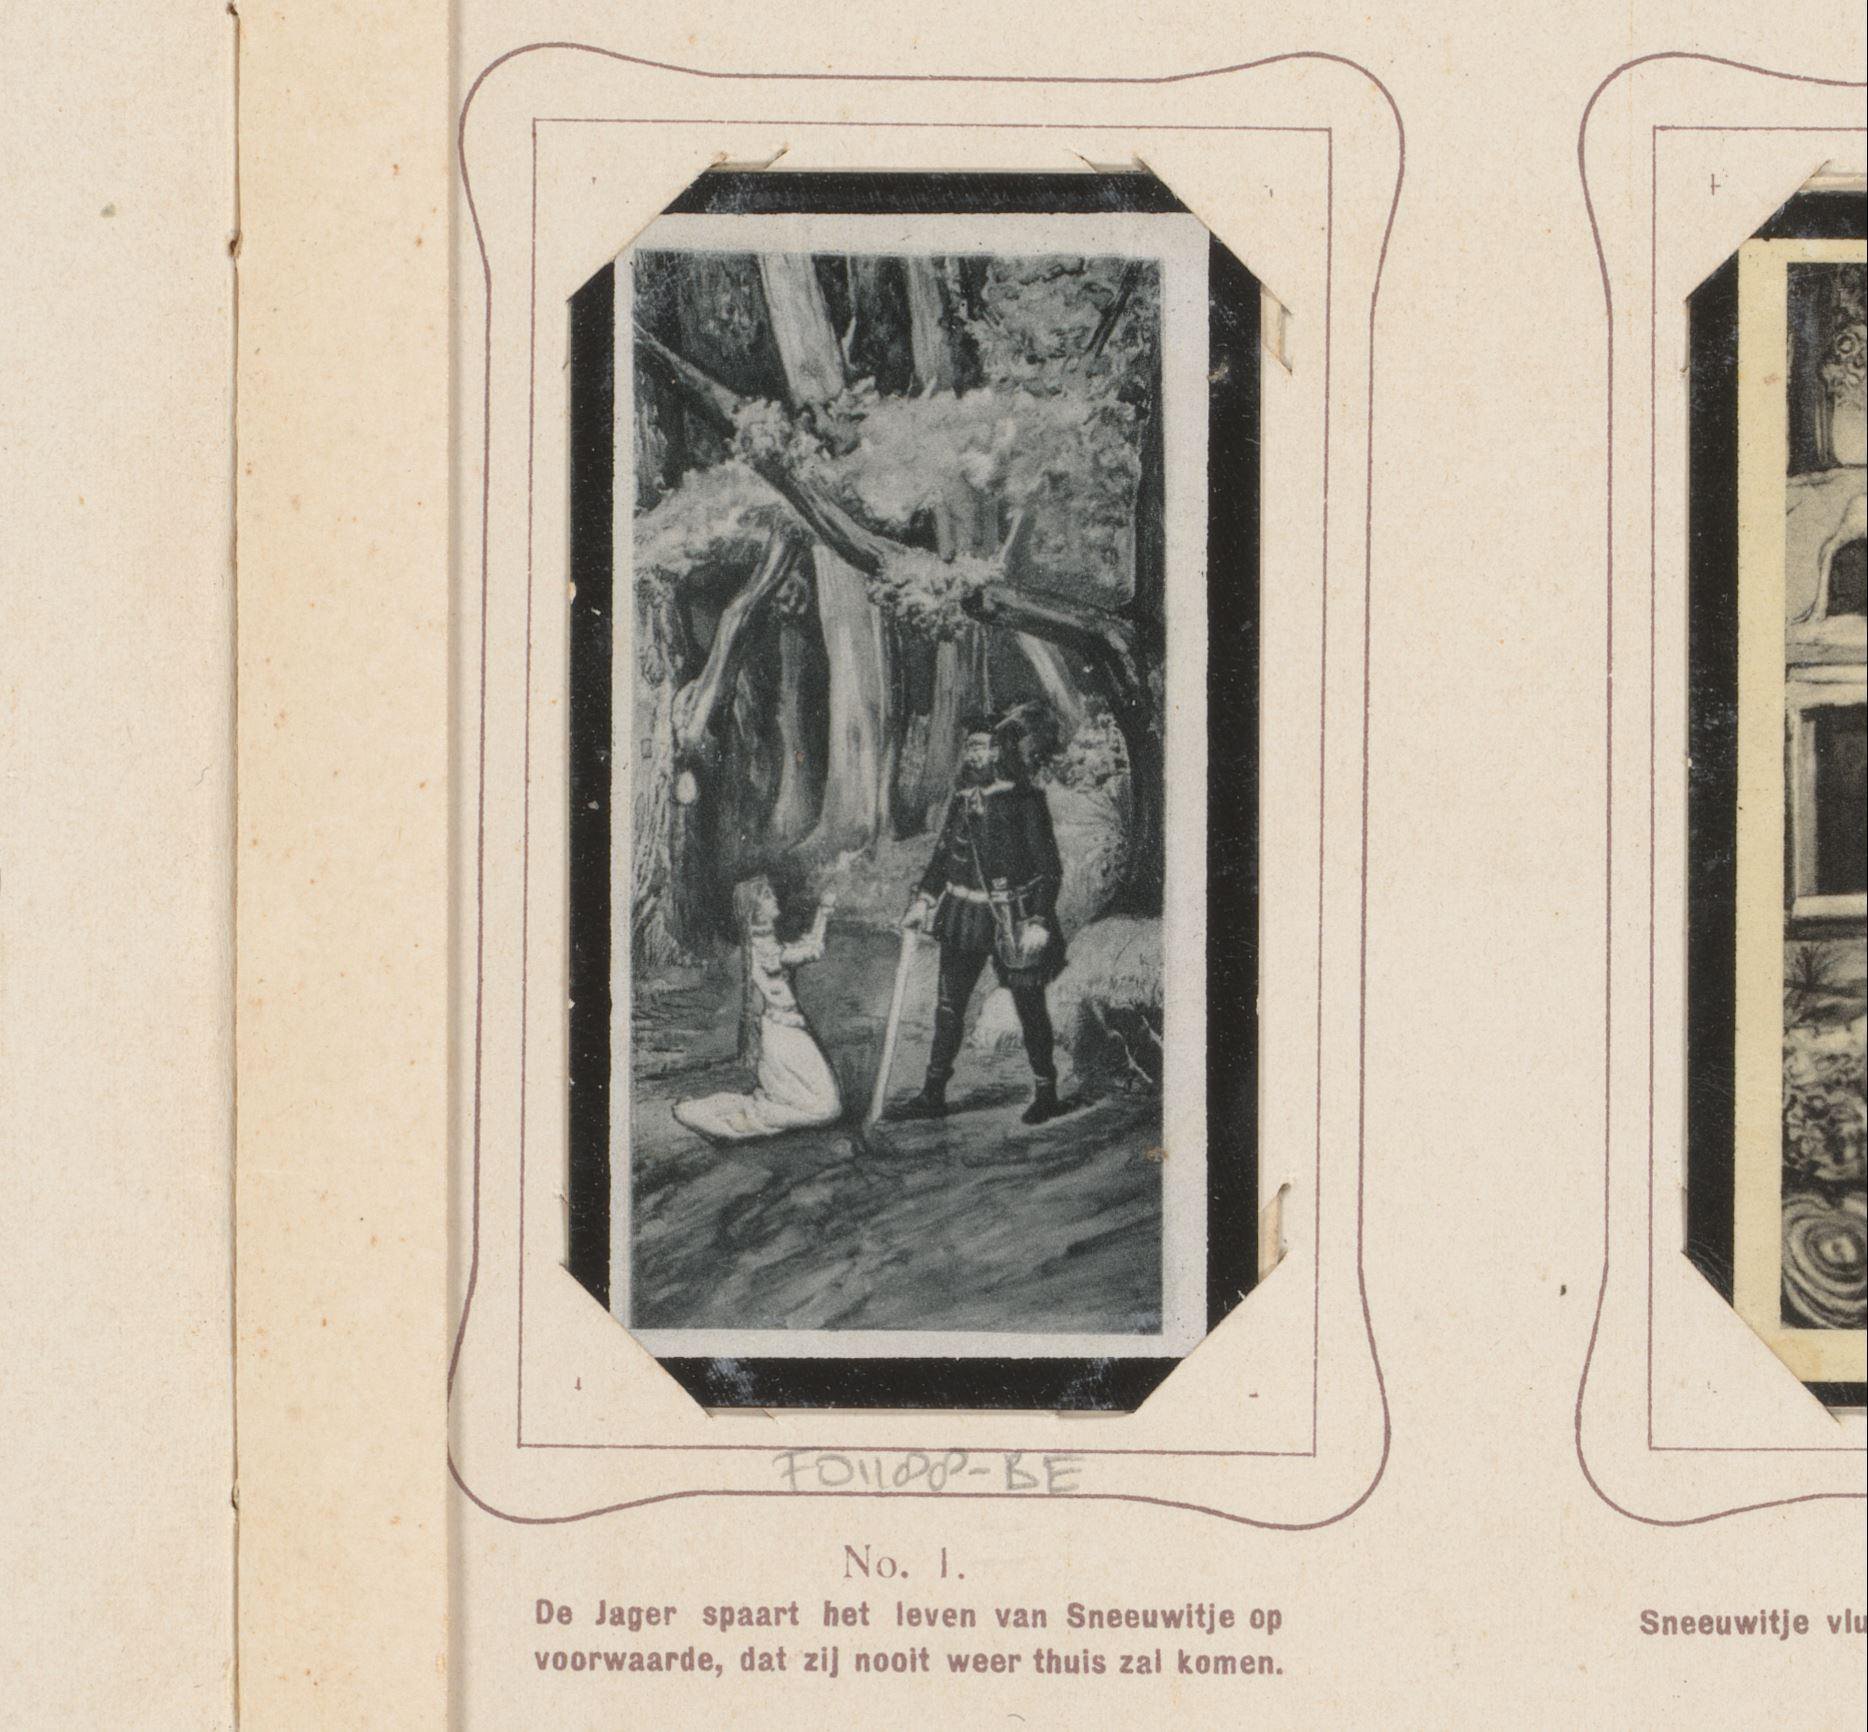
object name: photomechanical print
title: Sneeuwwitje en de jager in het bos, hij spaart haar leven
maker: Anonymous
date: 1906-1907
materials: paper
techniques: photograph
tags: tales and fairy tales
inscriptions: inscription: ‘No. 1./ De jager spaart het leven van Sneeuwitje op voorwaarde, dat zij nooit weer thuis zal komen.’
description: Deze prent maakt deel uit van een album.